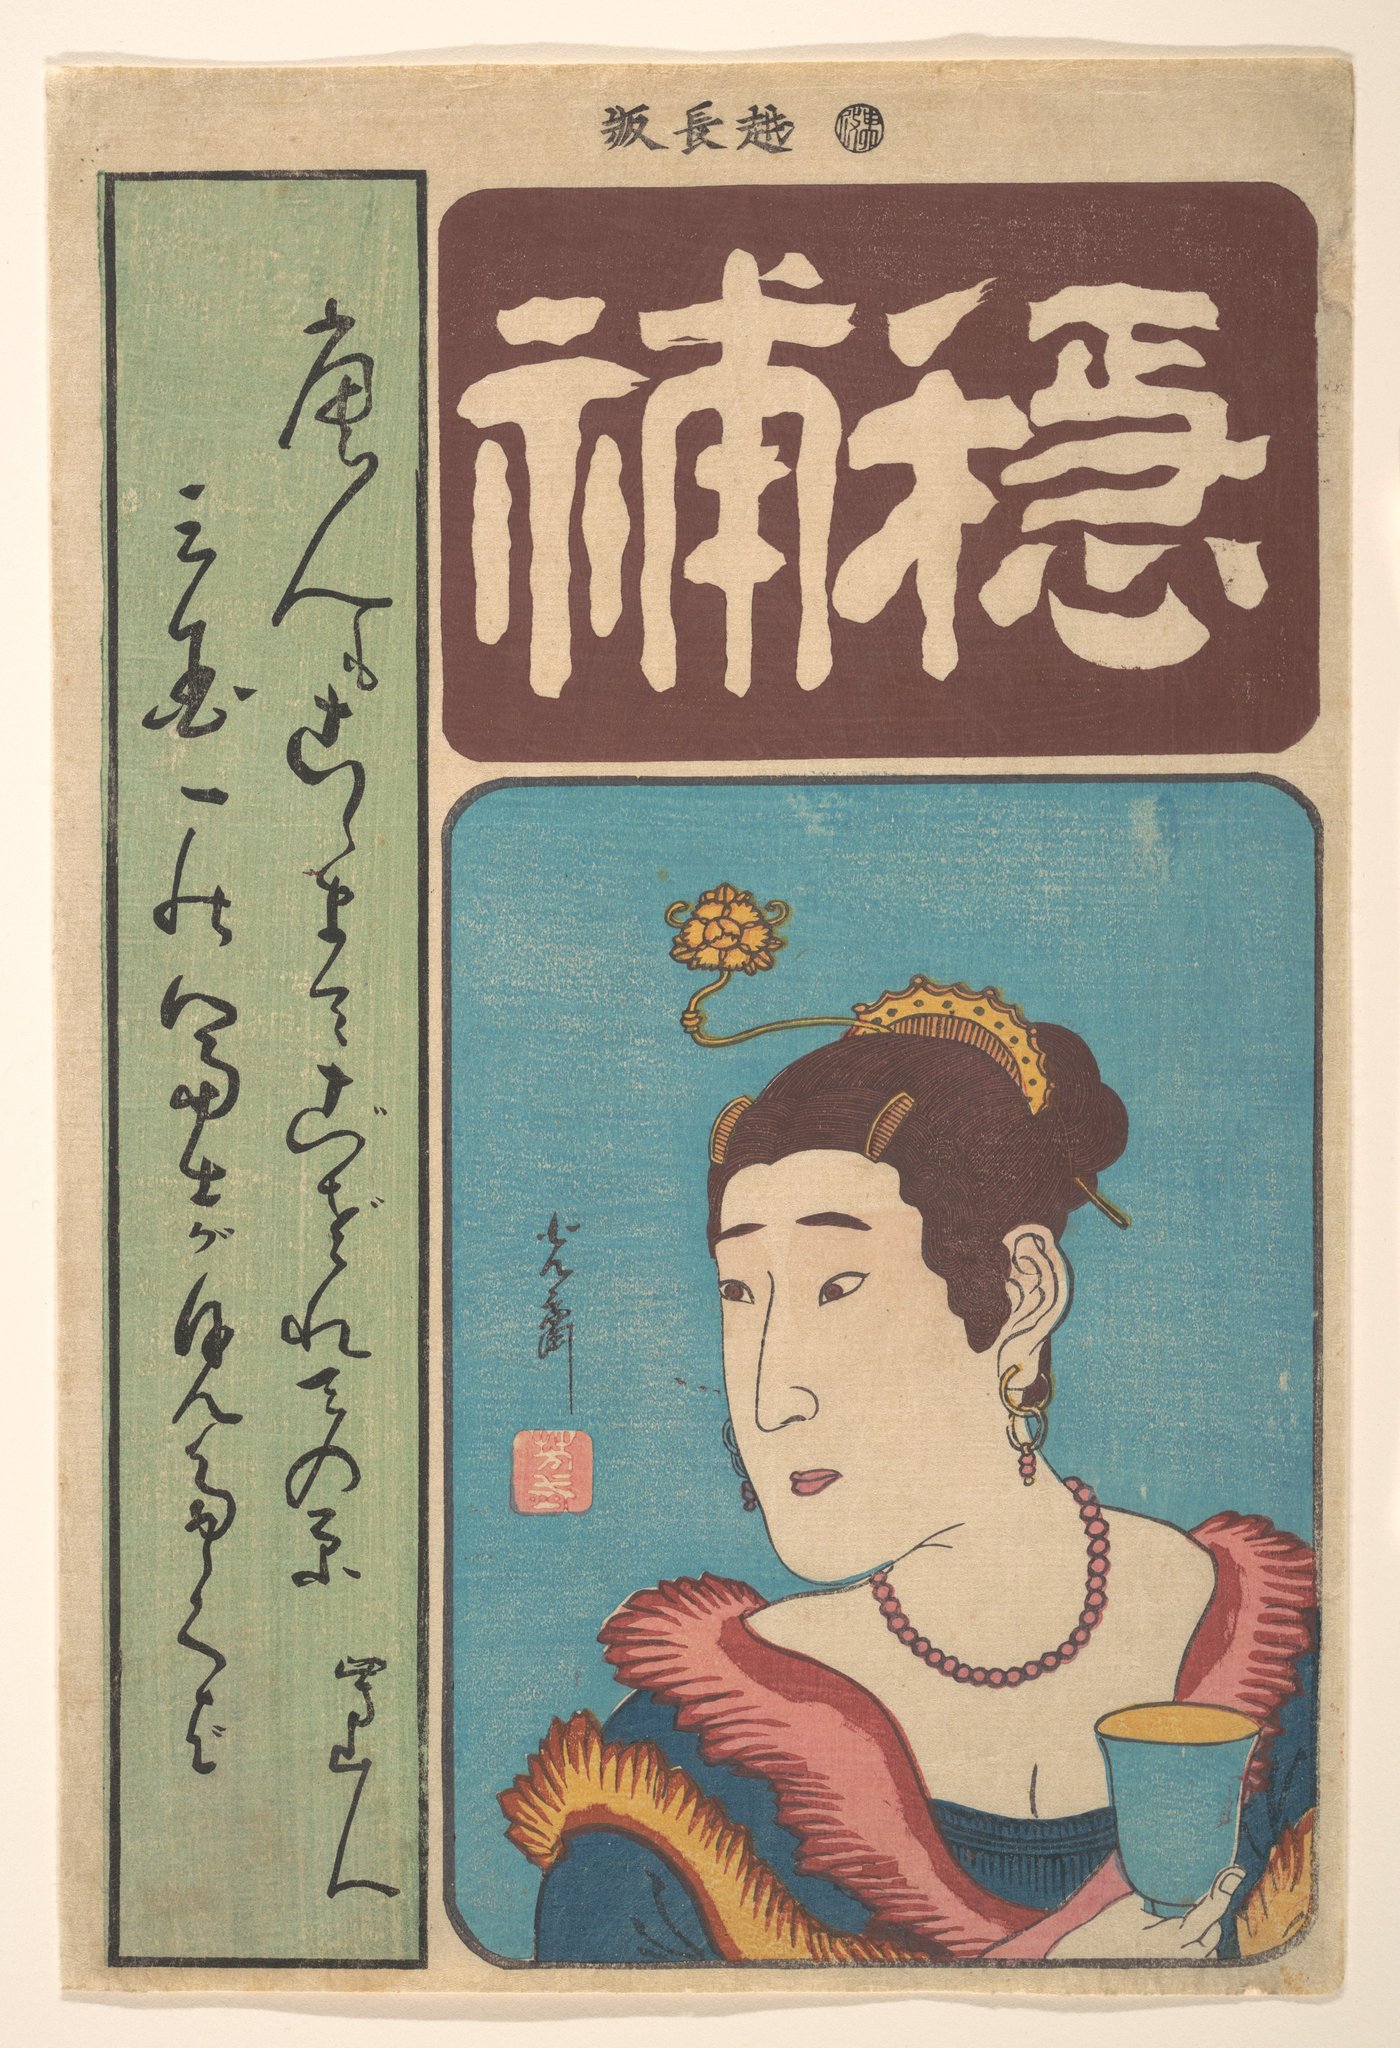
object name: print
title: Portrait of Okichi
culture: japanese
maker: utagawa yoshimori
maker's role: artist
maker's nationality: japanese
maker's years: 1830-1884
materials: ink, paper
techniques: woodblock print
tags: portraits,women